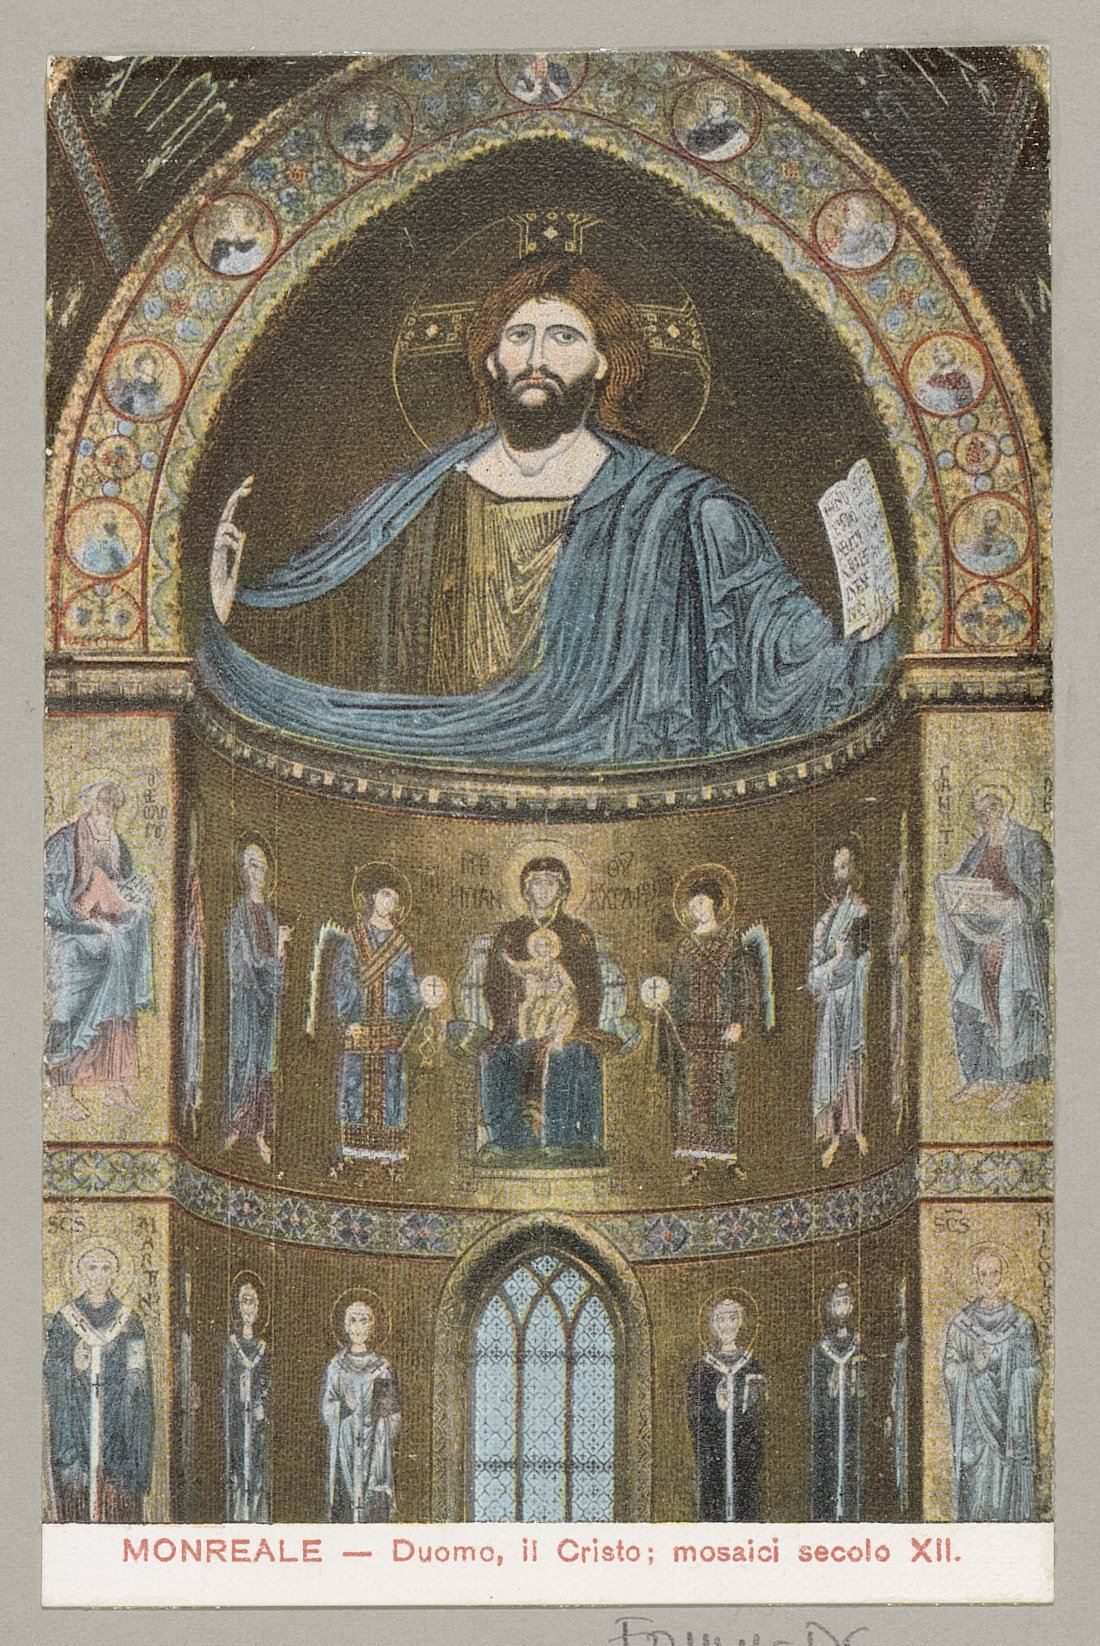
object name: ansichtkaart, prentbriefkaart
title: Mozaïek van Christus in de Kathedraal van Monreale op Sicilië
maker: Anonymous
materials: paper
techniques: color autotype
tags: parts of church interior: apse, christ as adult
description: Onderdeel van Fotoalbum van een reis door Zuid-Europa en het Midden-Oosten.